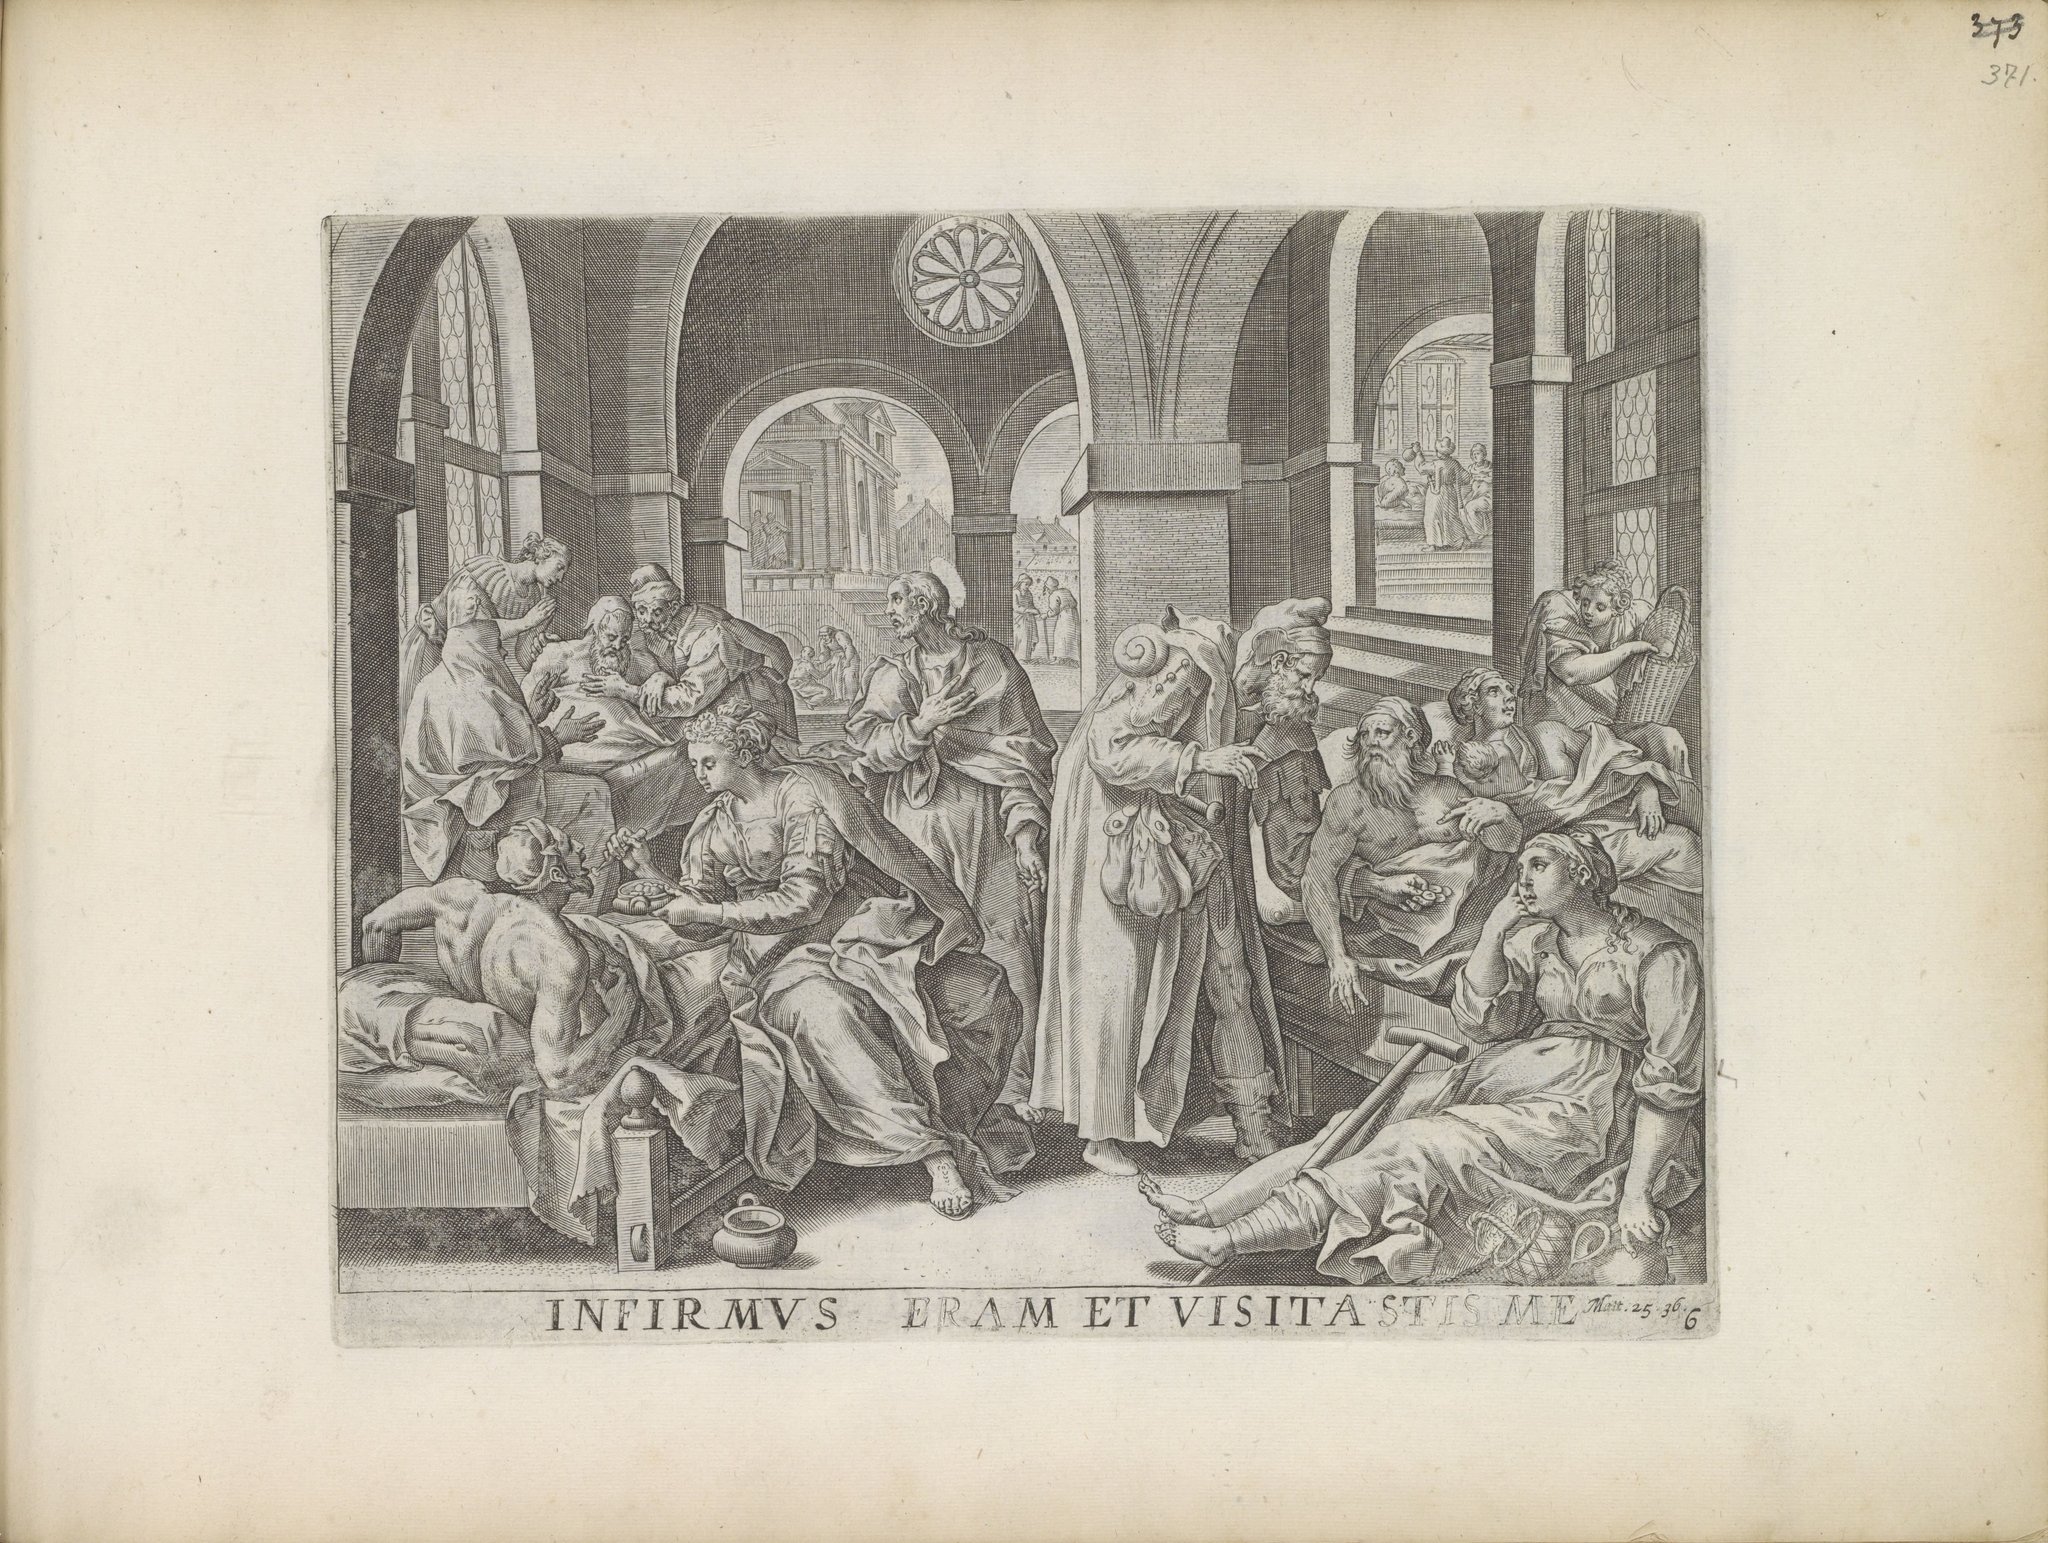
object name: album leaf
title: Zeven werken van barmhartigheid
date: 1585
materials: paper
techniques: engraving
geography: amsterdam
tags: visiting the sick, 'aeger curatur' ~ one of the (seven) acts of mercy - vv - christ present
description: In een hospitaal verzorgen mensen de zieken. Links geeft een vrouw een man te eten. Rechts geeft een man wat geld weg. Christus staat in het midden van de ruimte. Onder de voorstelling een verwijzing in het Latijn naar de Bijbeltekst in Mat. 25:36. Deze prent maakt deel uit van een album.